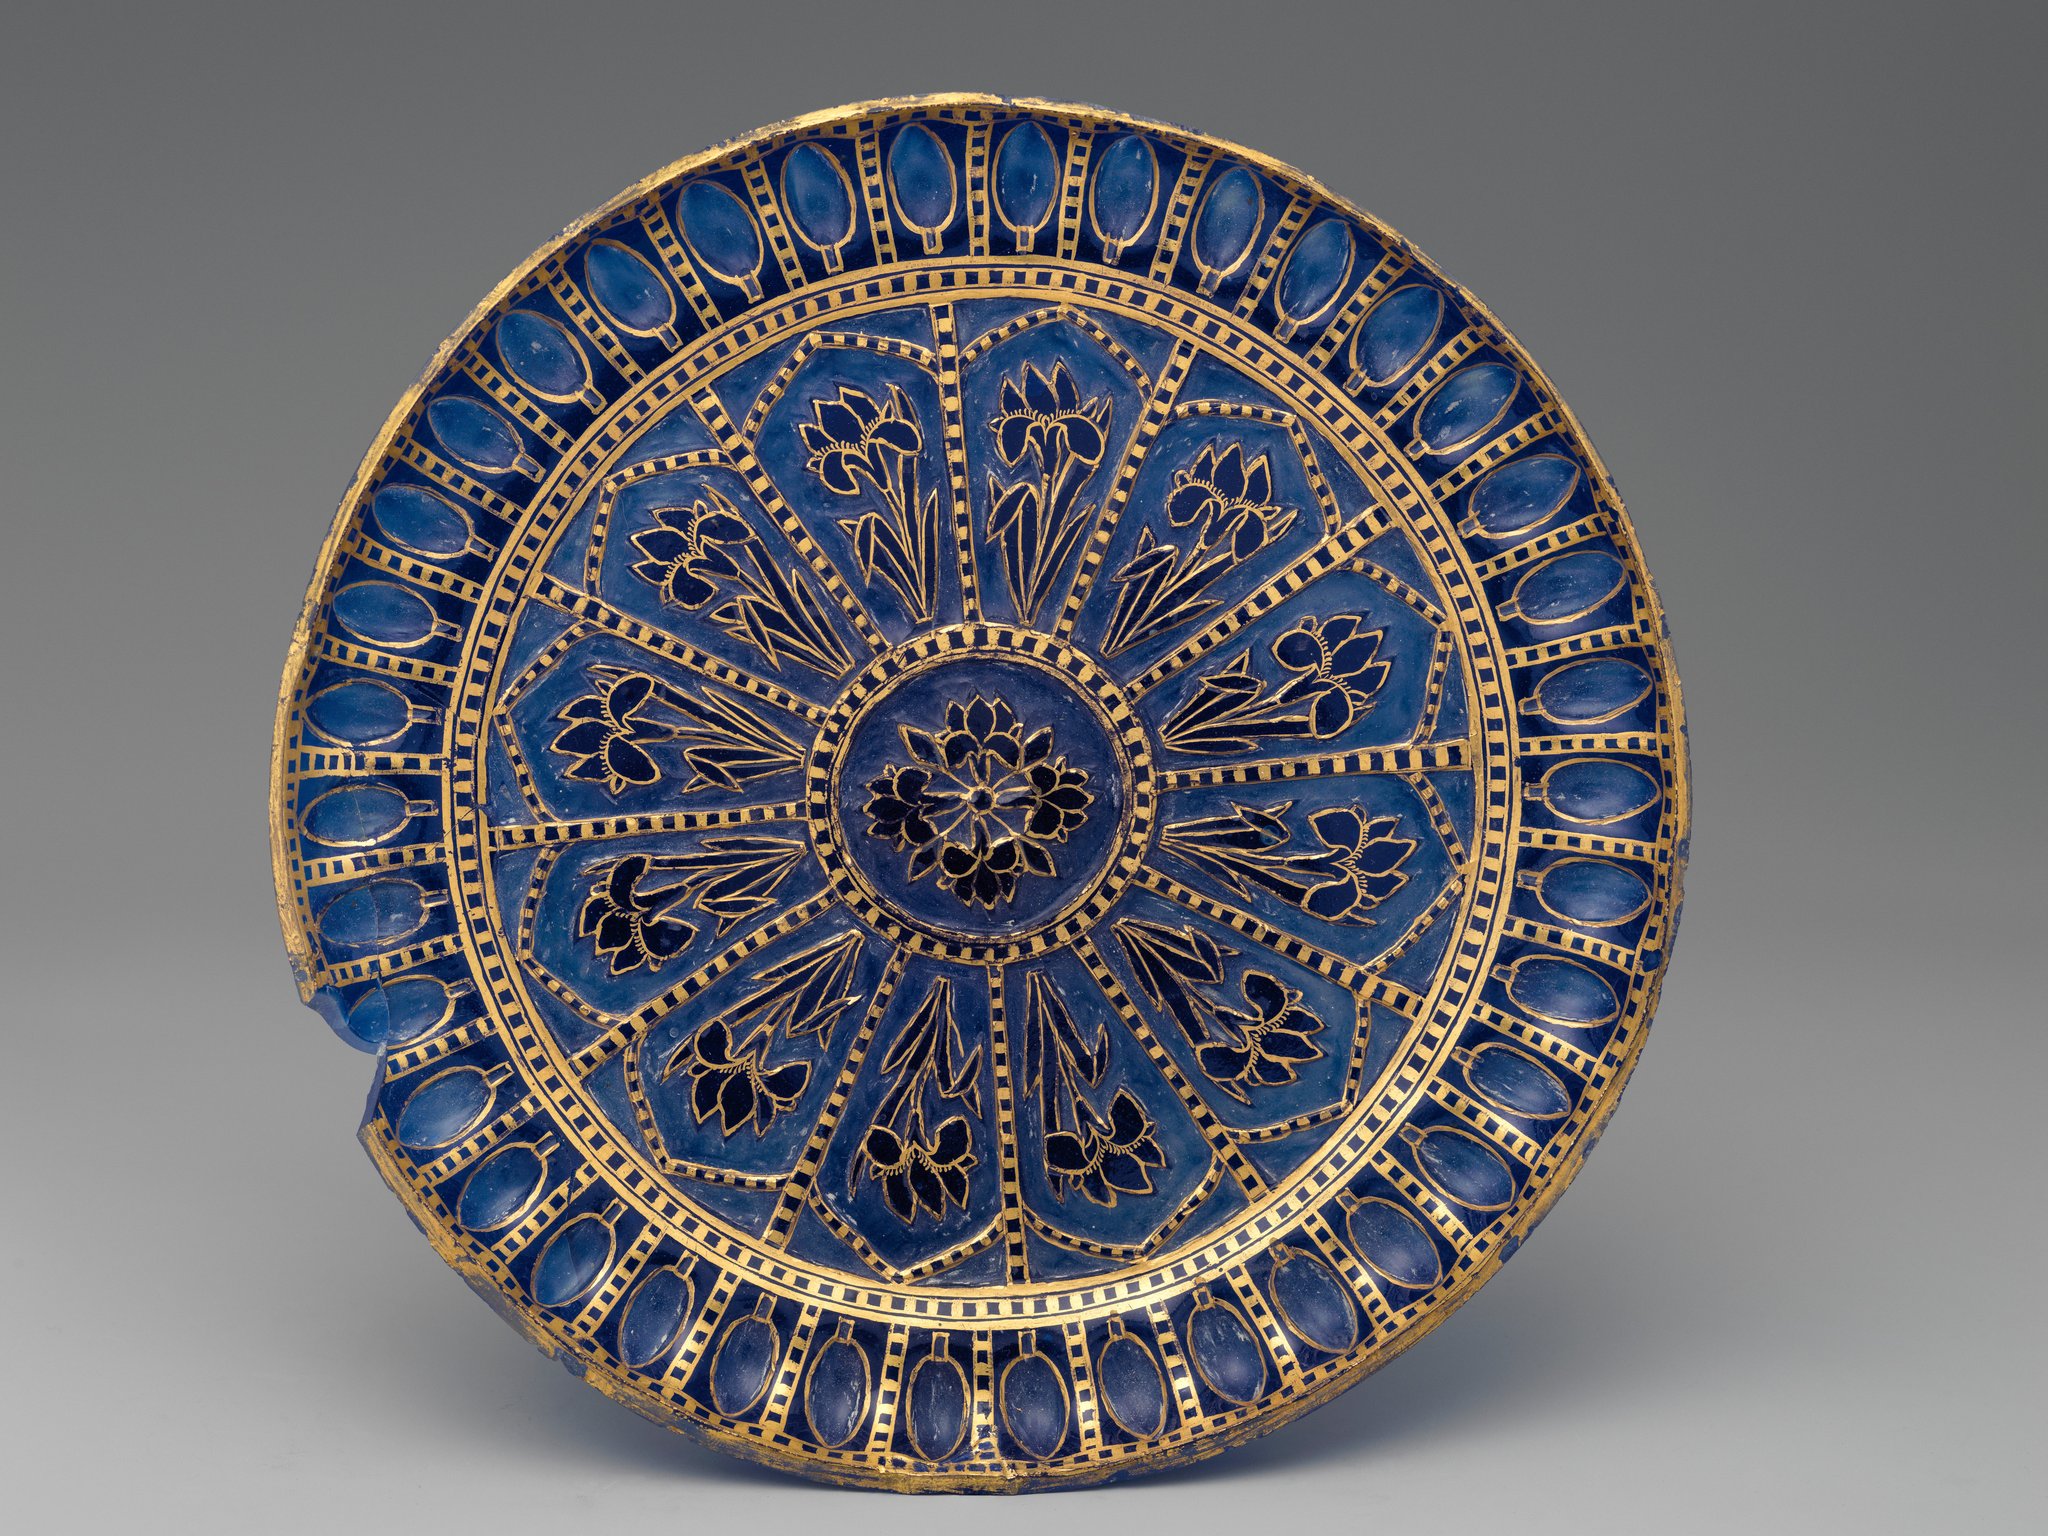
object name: plate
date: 1701-1750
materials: glass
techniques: glassblowing, cutting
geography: india